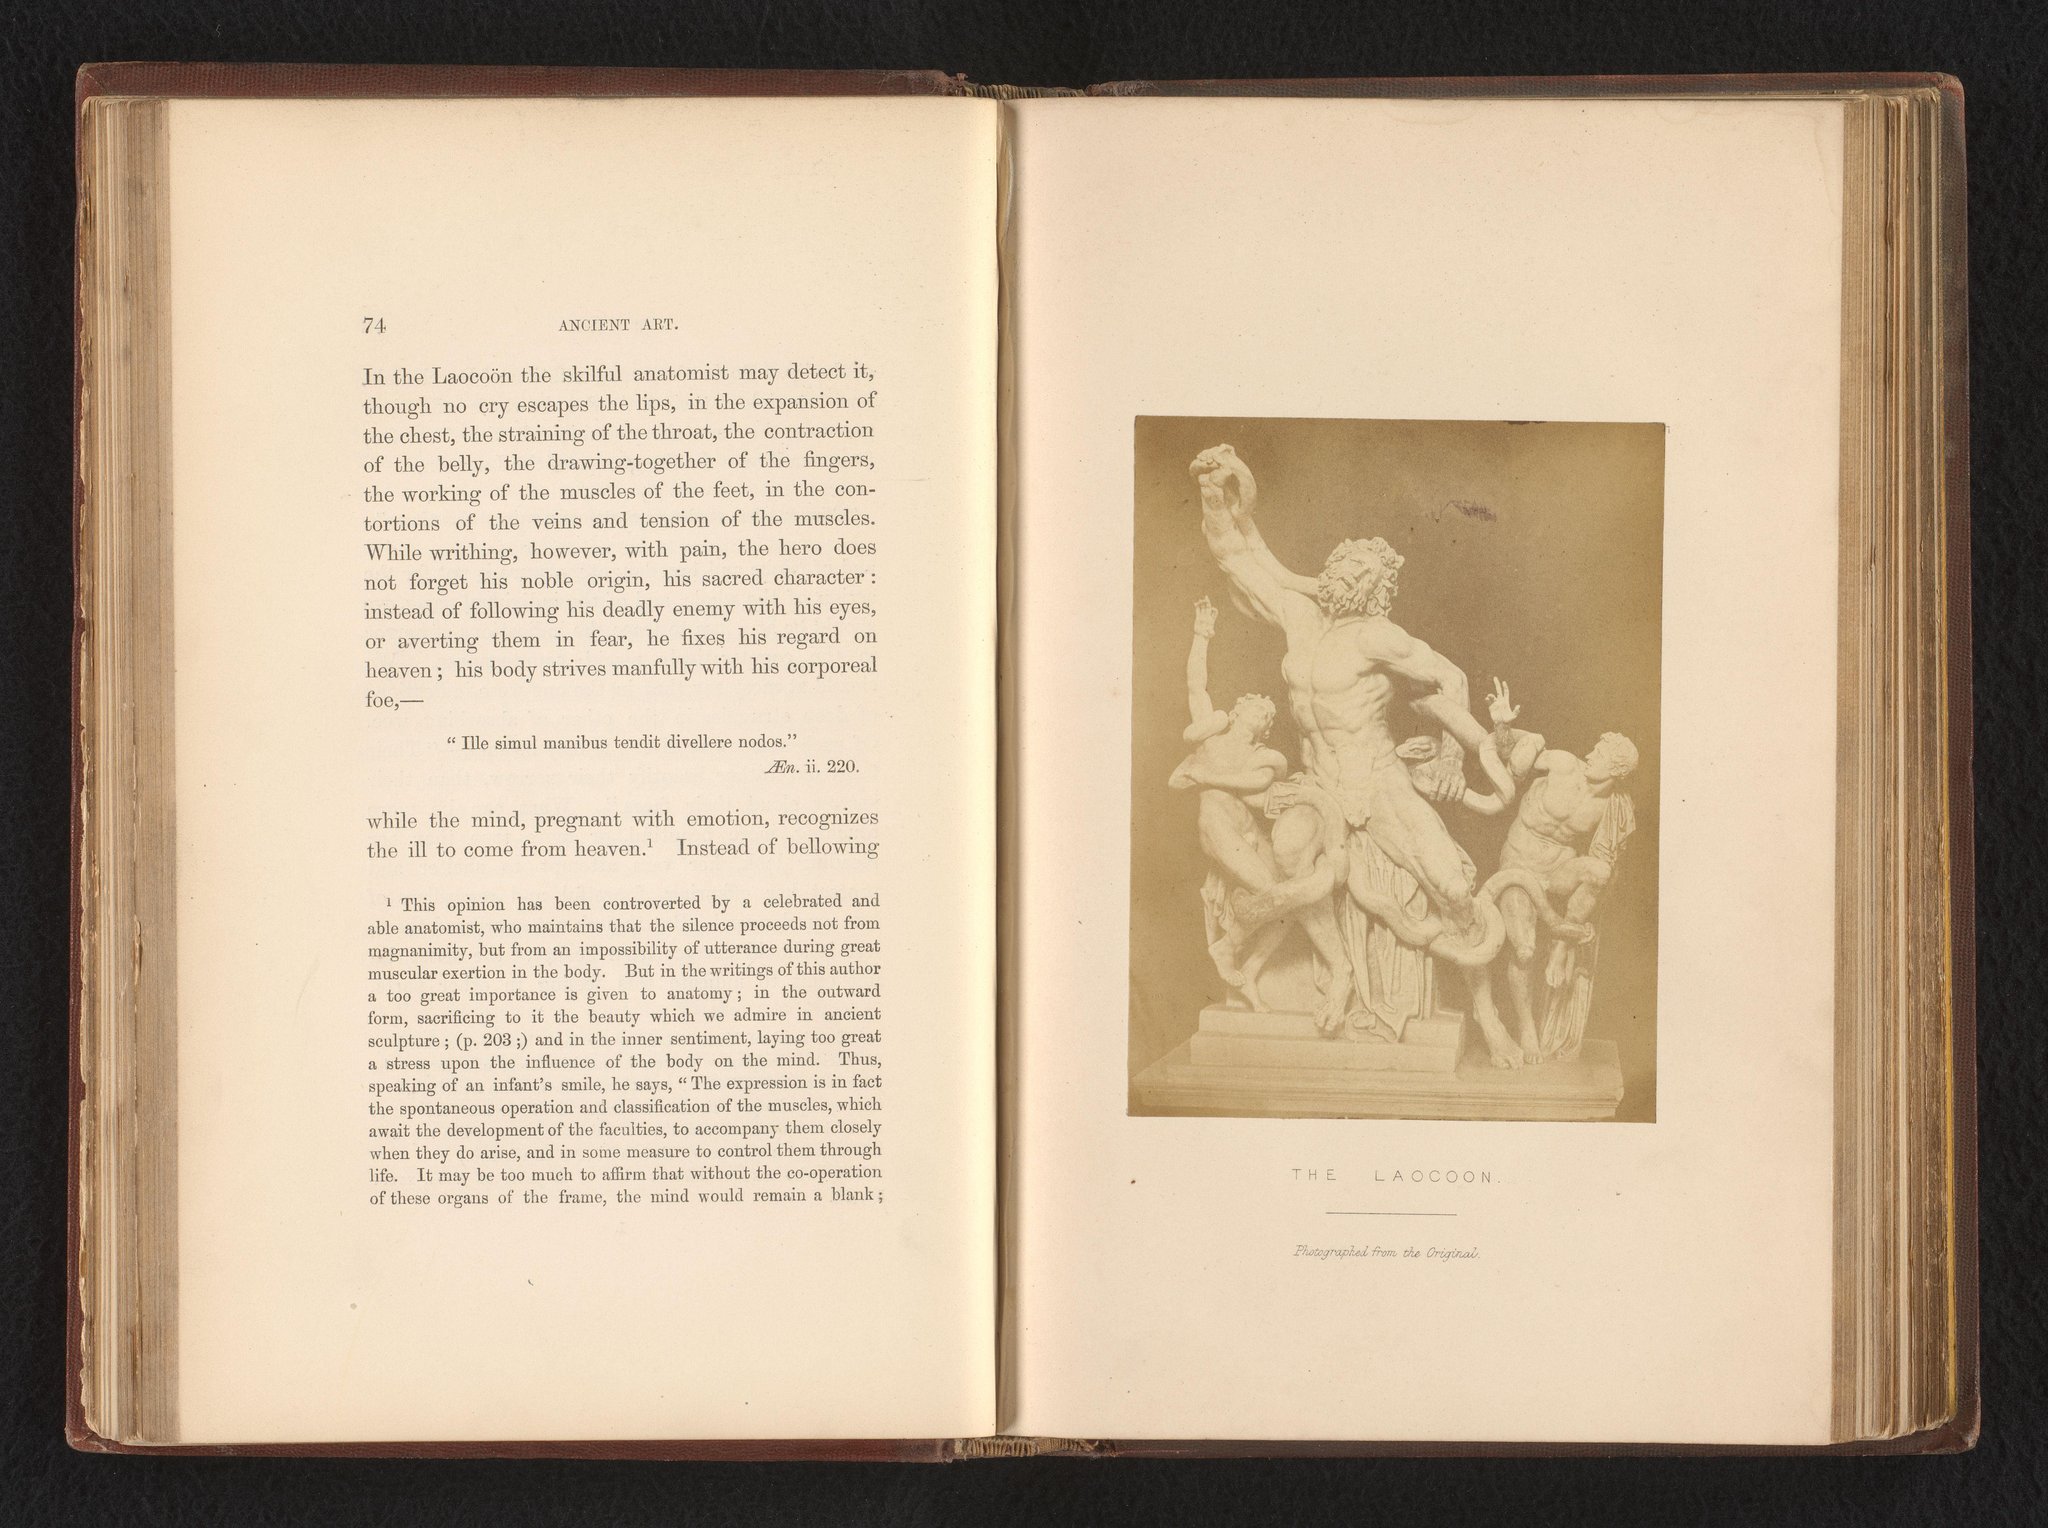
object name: page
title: The Laocoon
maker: Anonymous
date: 1855-1860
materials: paper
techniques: albumen print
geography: vatican city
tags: laocoon and his twin sons are strangled by two serpents during the preparations for a sacrifice, piece of sculpture, reproduction of a piece of sculpture